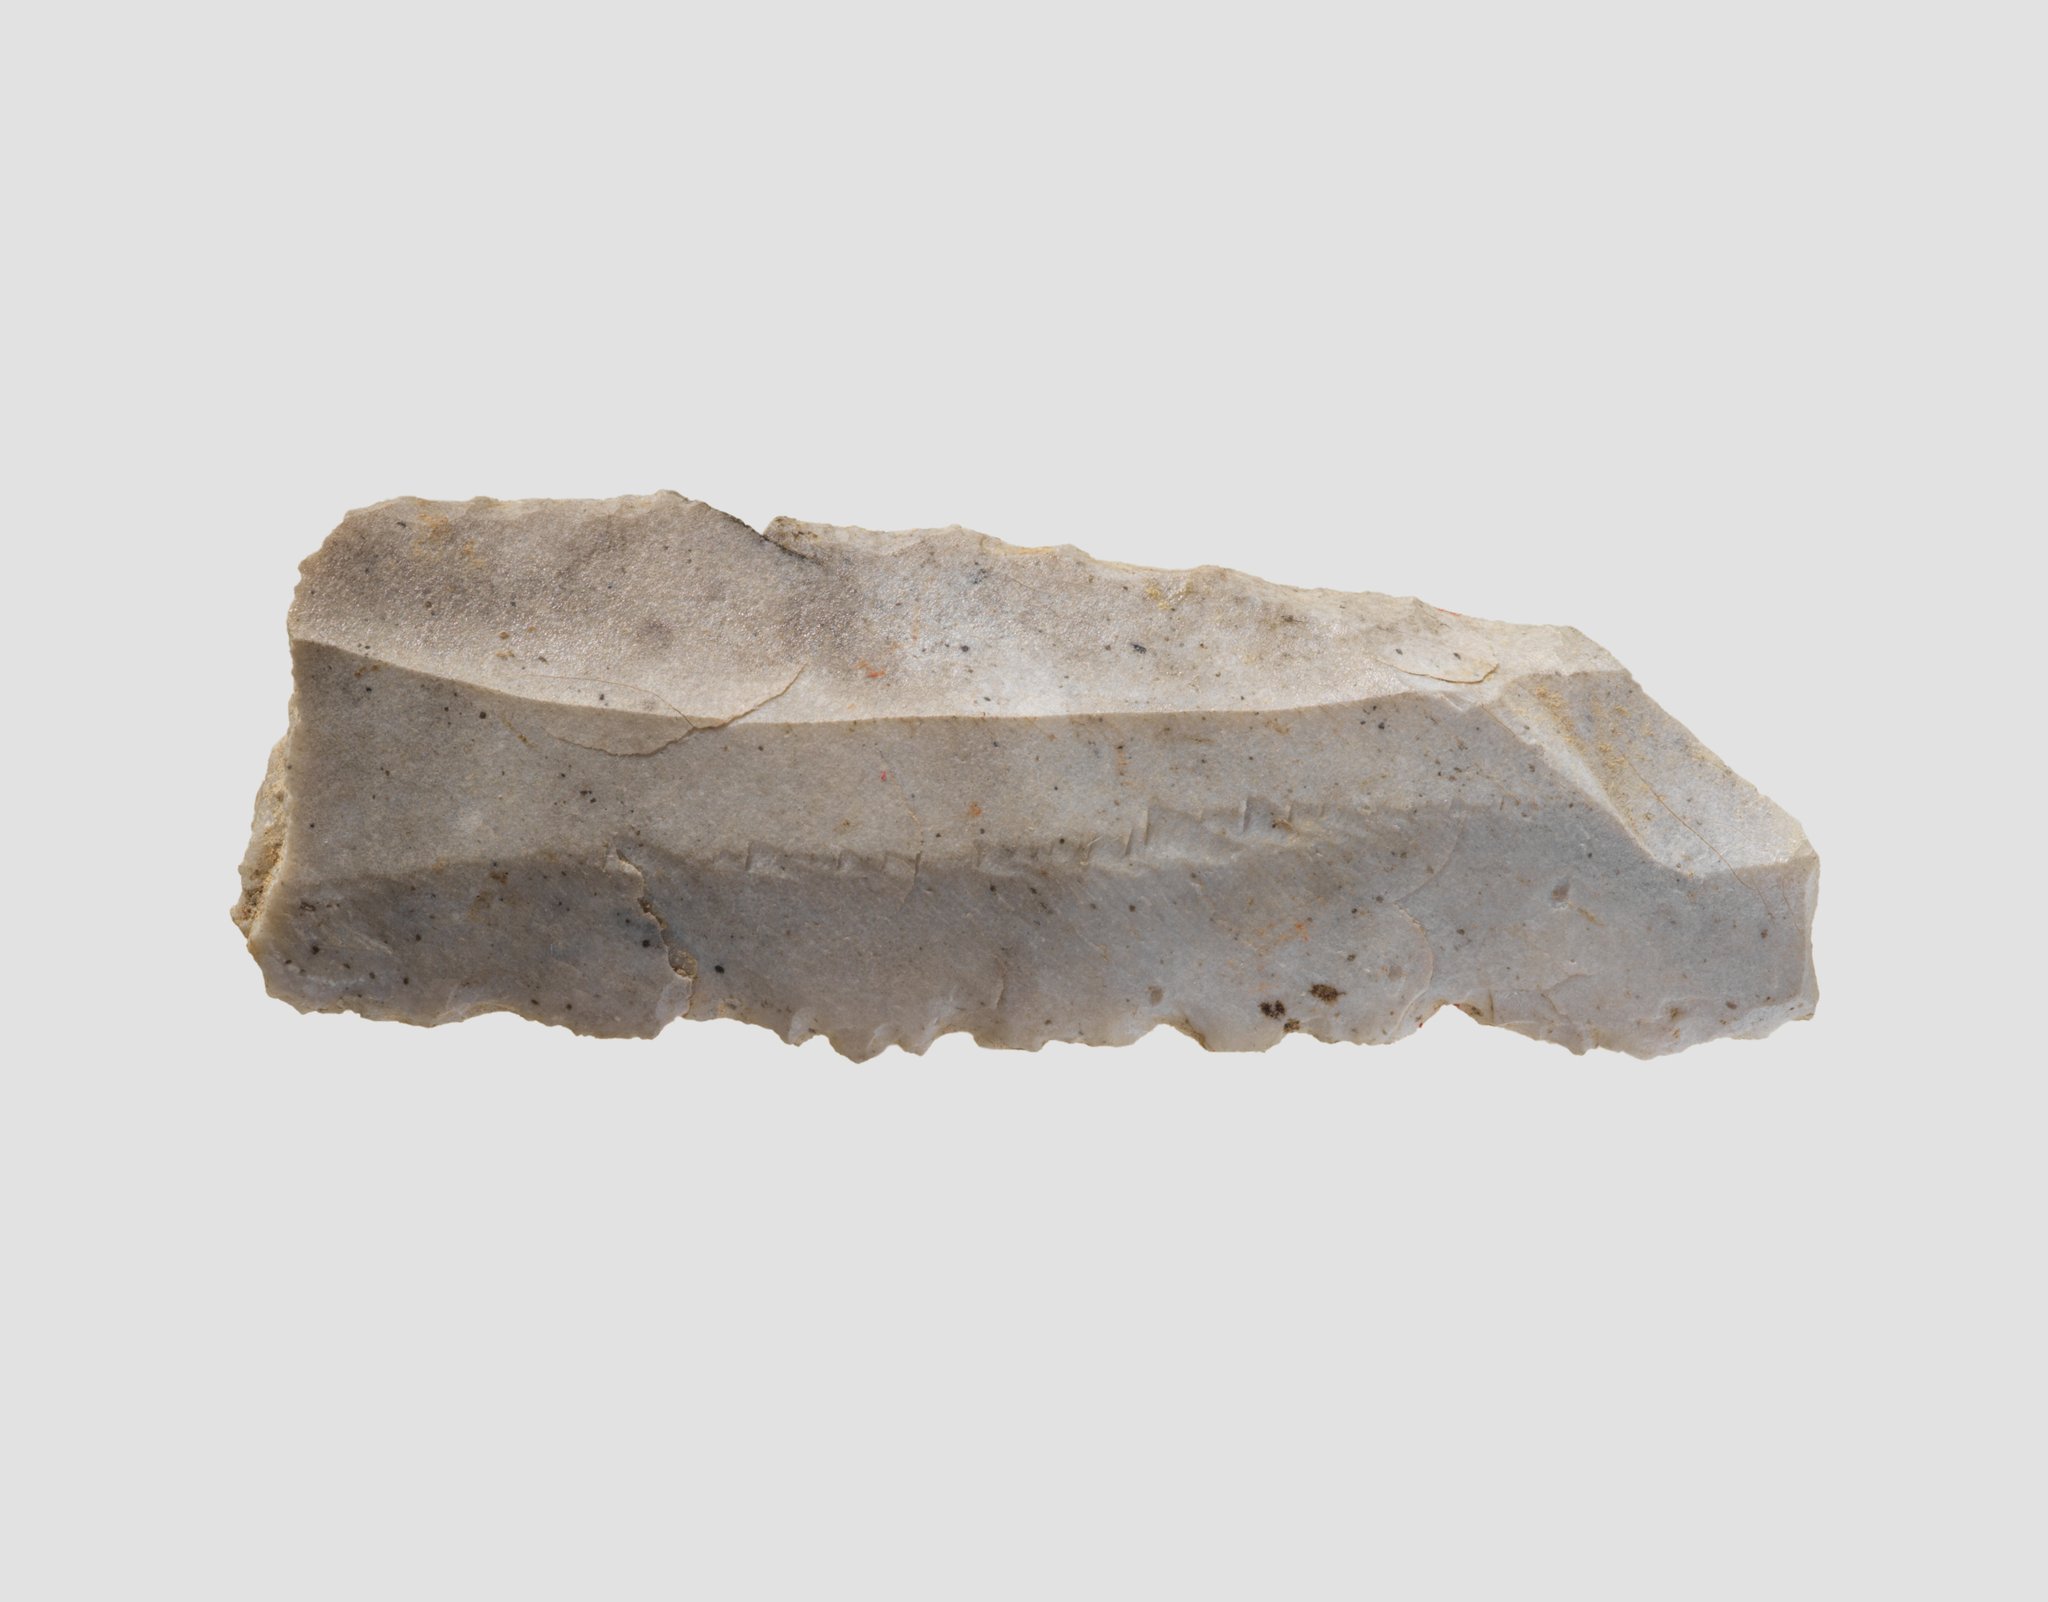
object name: knife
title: Blade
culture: ghassulian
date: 4600-3600 BCE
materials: stone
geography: levant